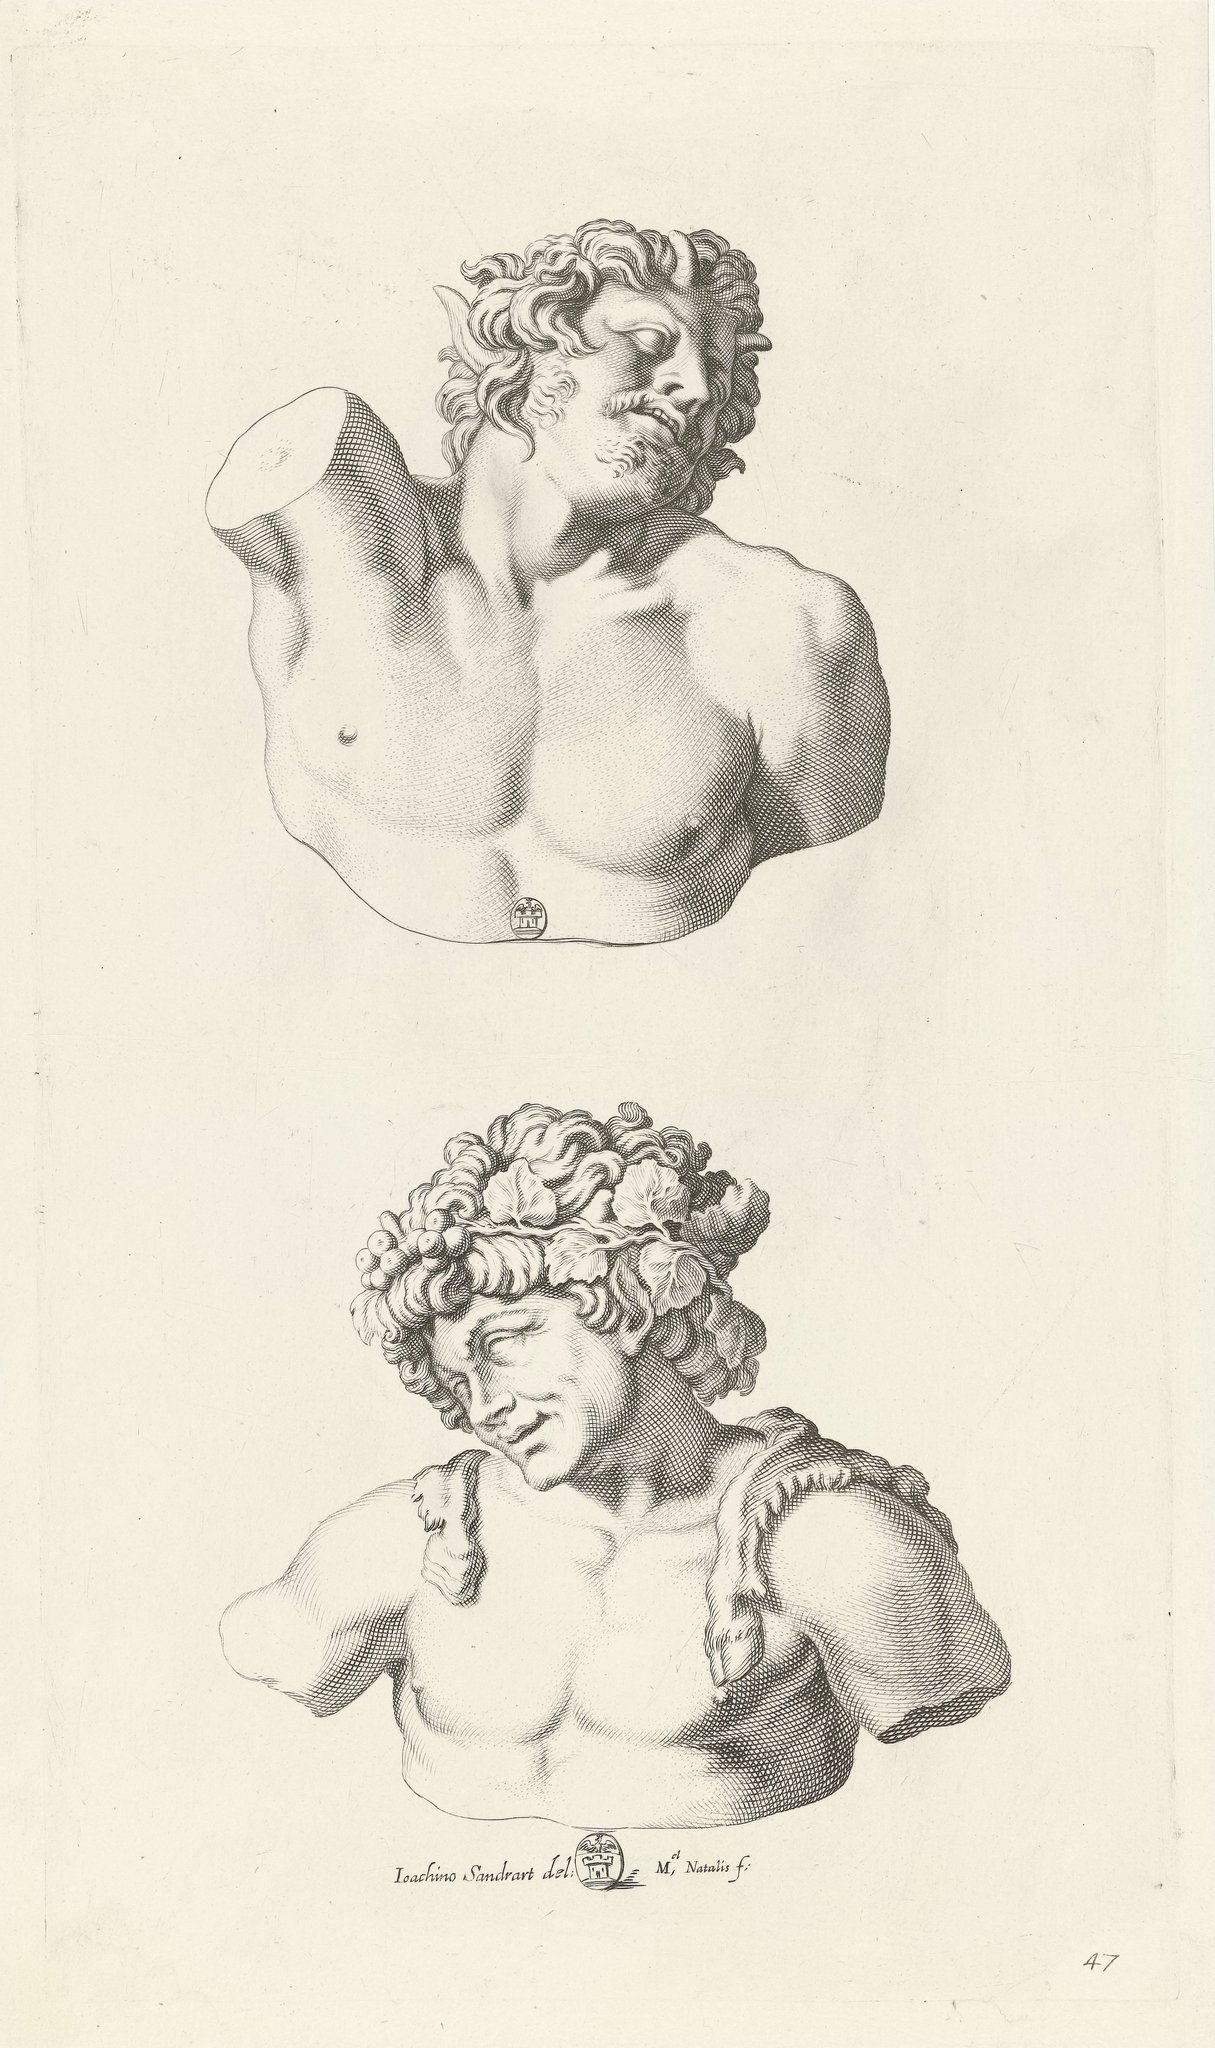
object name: print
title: Galleria Giustiniana del Marchese Vincenzo Giustiniani II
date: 1640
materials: paper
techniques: engraving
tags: rome, vincenzo giustiniani (1564-1637), satyrs, fauns, sileni, piece of sculpture, reproduction of a piece of sculpture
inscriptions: collector's mark: Lugt 2228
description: Twee Romeinse sculpturen. Boven de buste van een faun met hoorns op het hoofd. Onder de buste van een faun, met wingerdbladeren en druiven in het haar, een geitenvel over de schouders. Middenonder beide beelden het wapenschild van Vincenzo Giustiniani. Prent uit een serie naar de sculpturen in de verzameling in de Galleria Giustiniani te Rome.